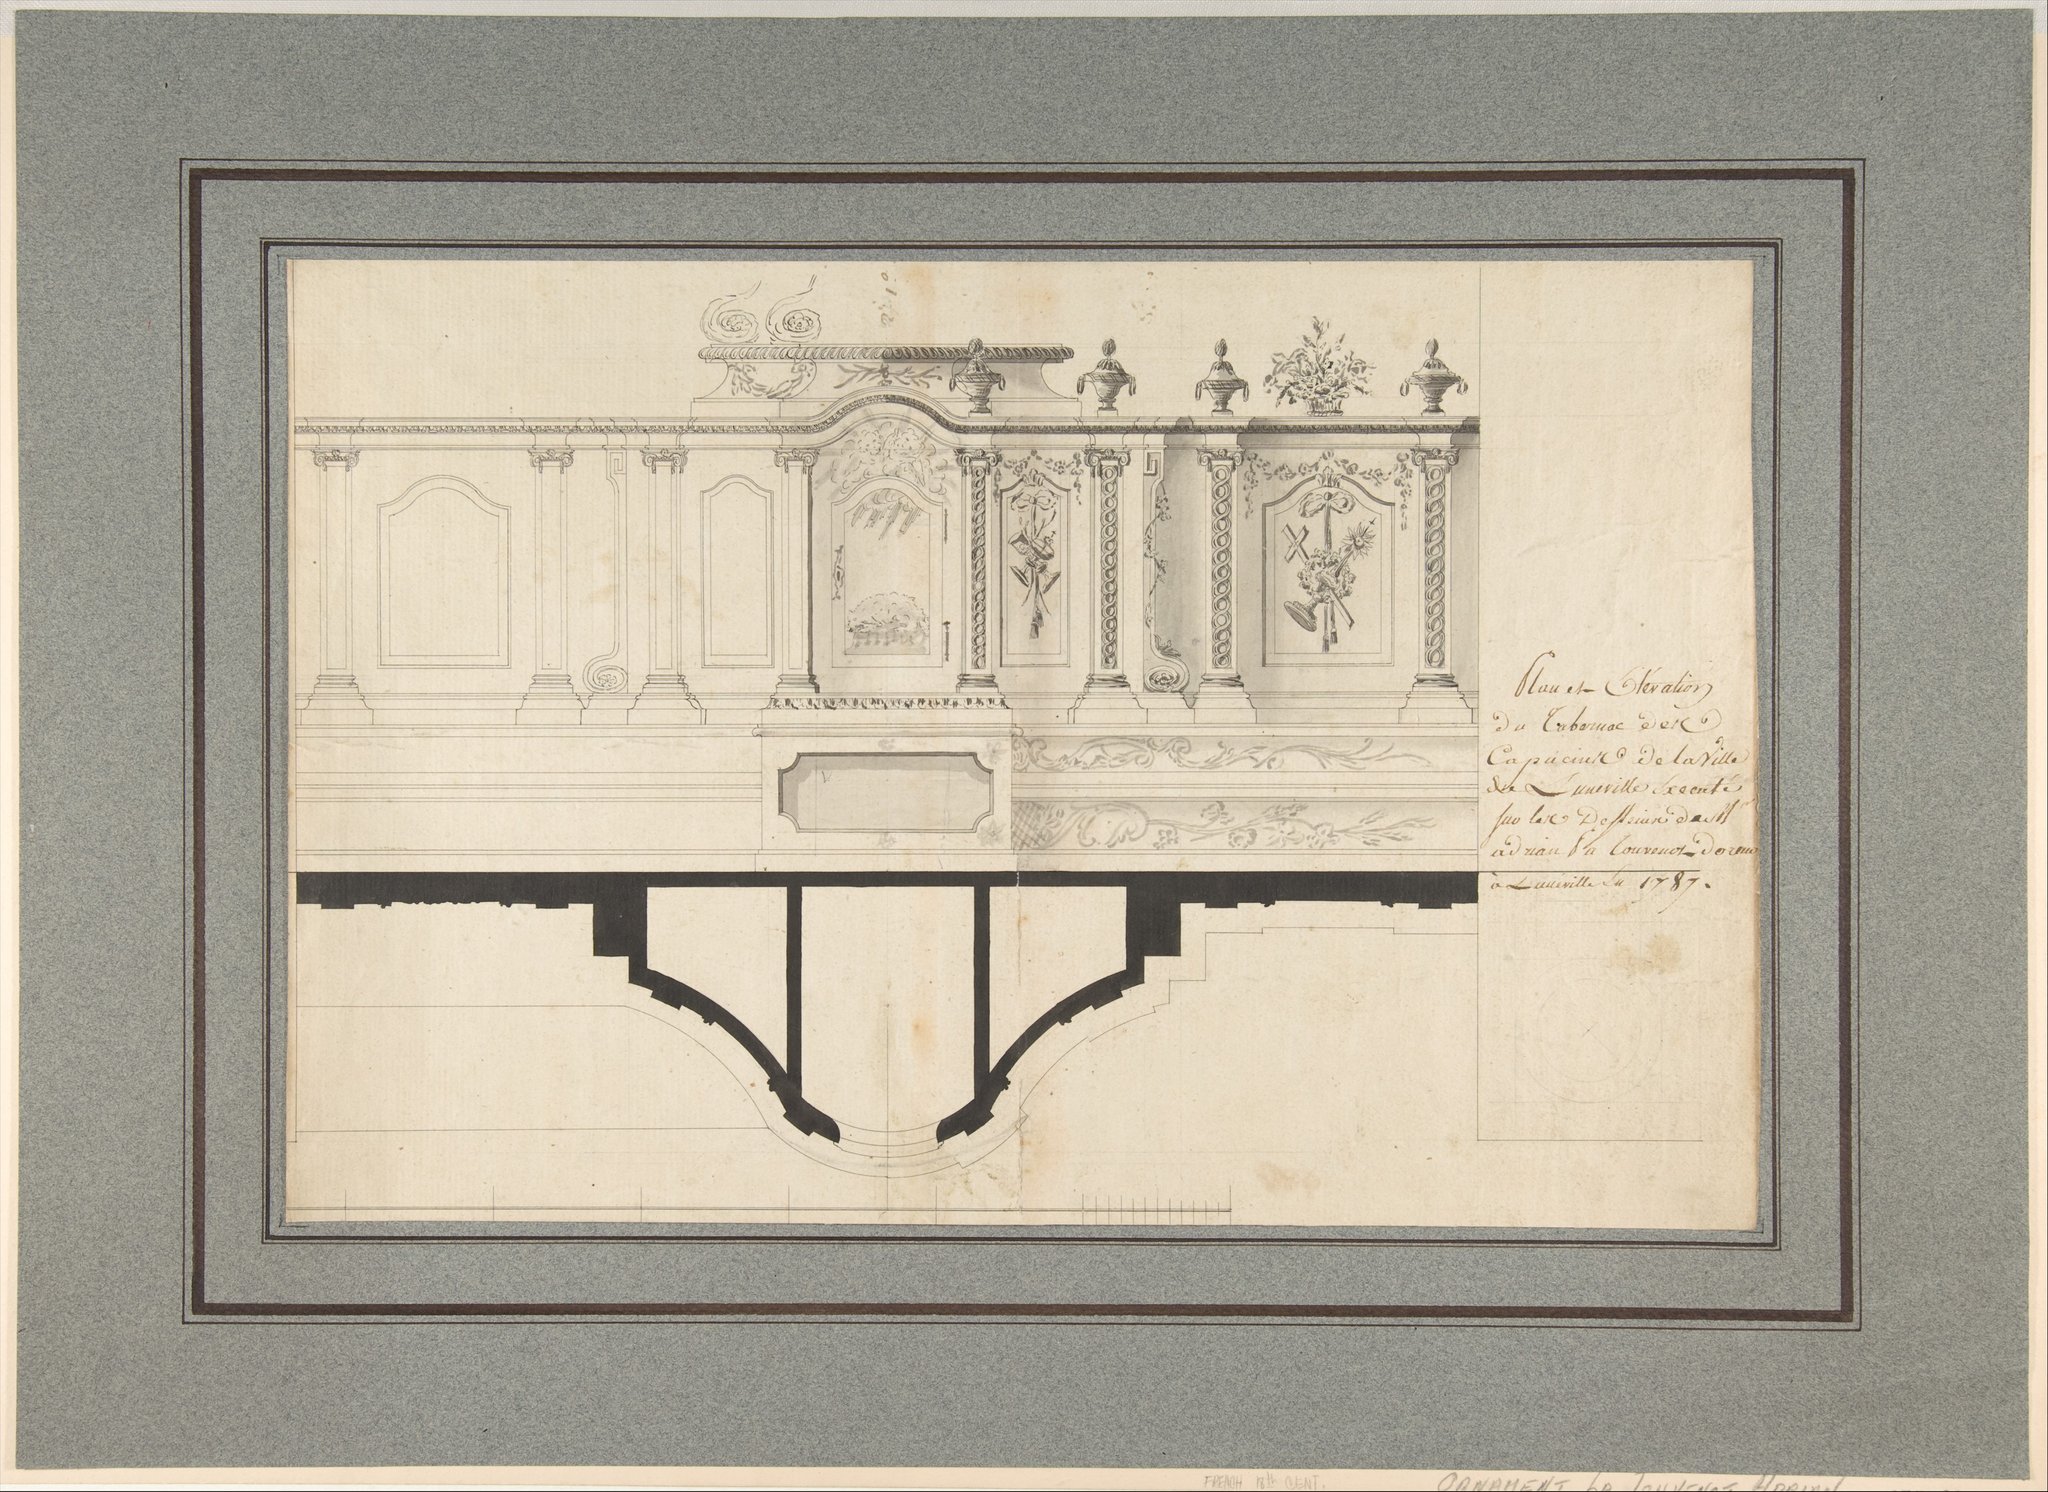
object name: drawing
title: Plan and Elevation of the Capuchin Tabernacle of Luneville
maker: adrian la touvenot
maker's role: artist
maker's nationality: french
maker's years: 1787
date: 1787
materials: graphite, ink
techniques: brush, pen, wash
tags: architecture